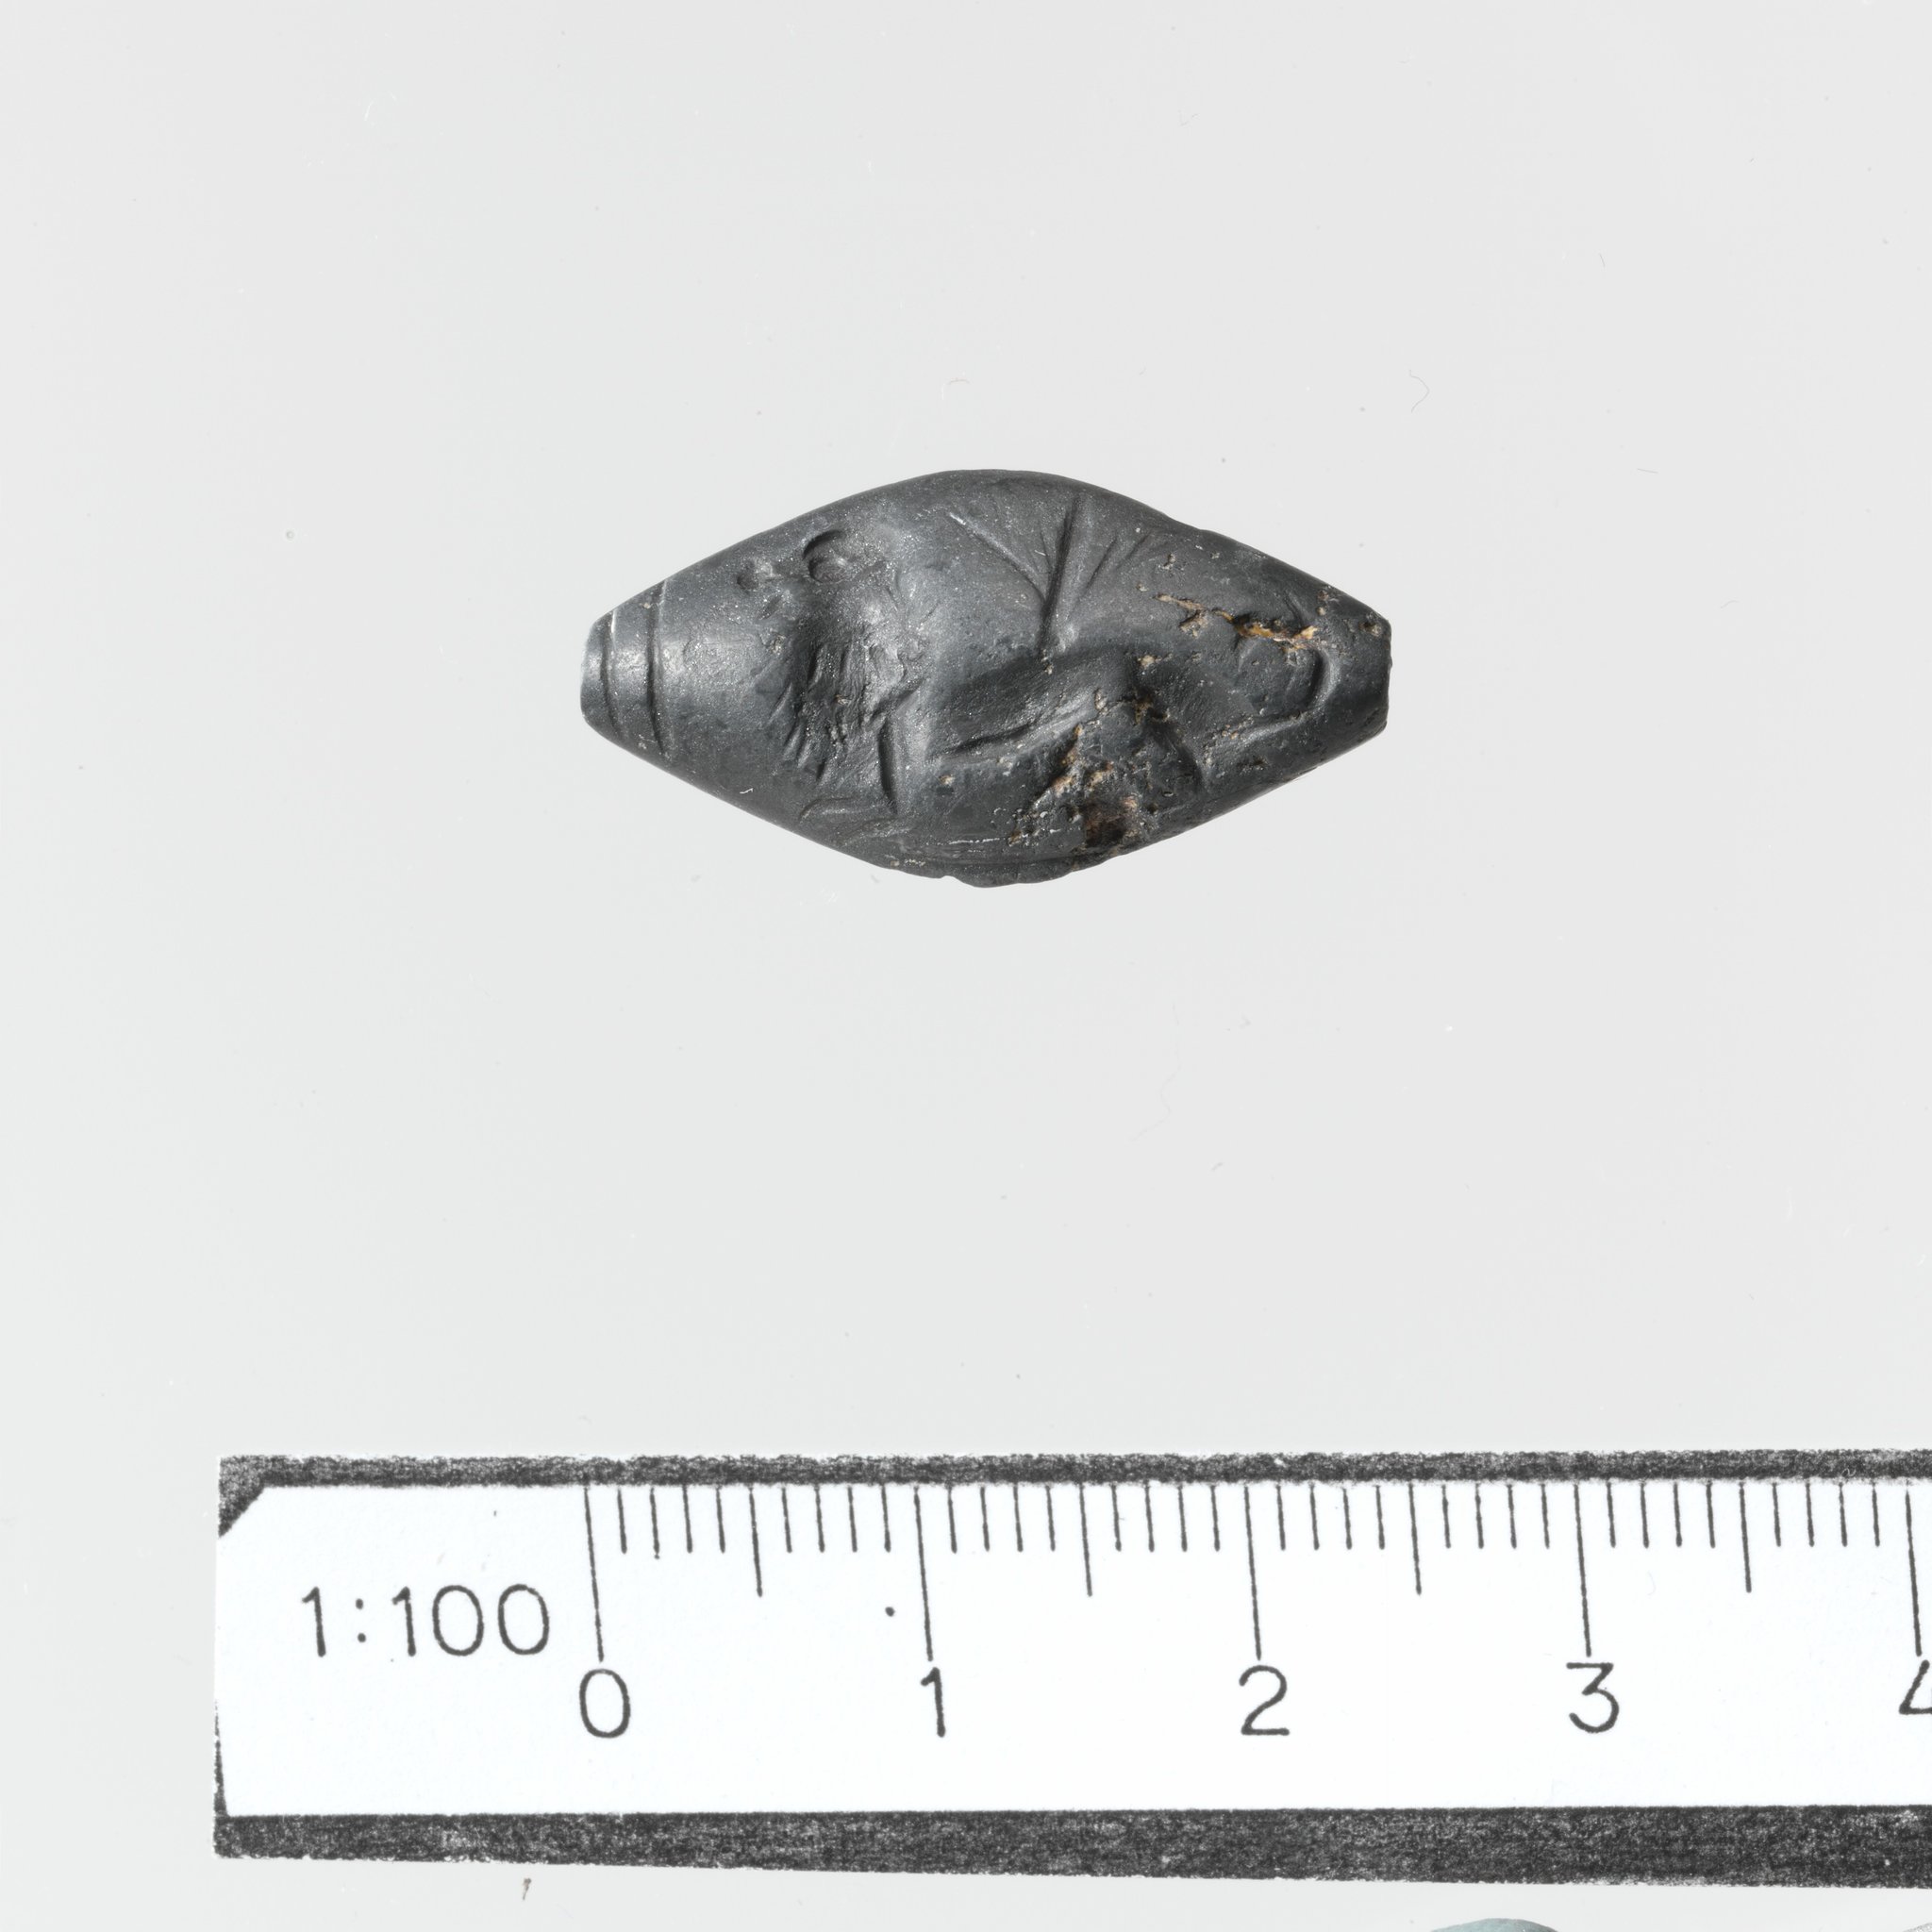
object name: seal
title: Haematite amygdaloid seal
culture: minoan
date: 1600-1450 BCE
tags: lions